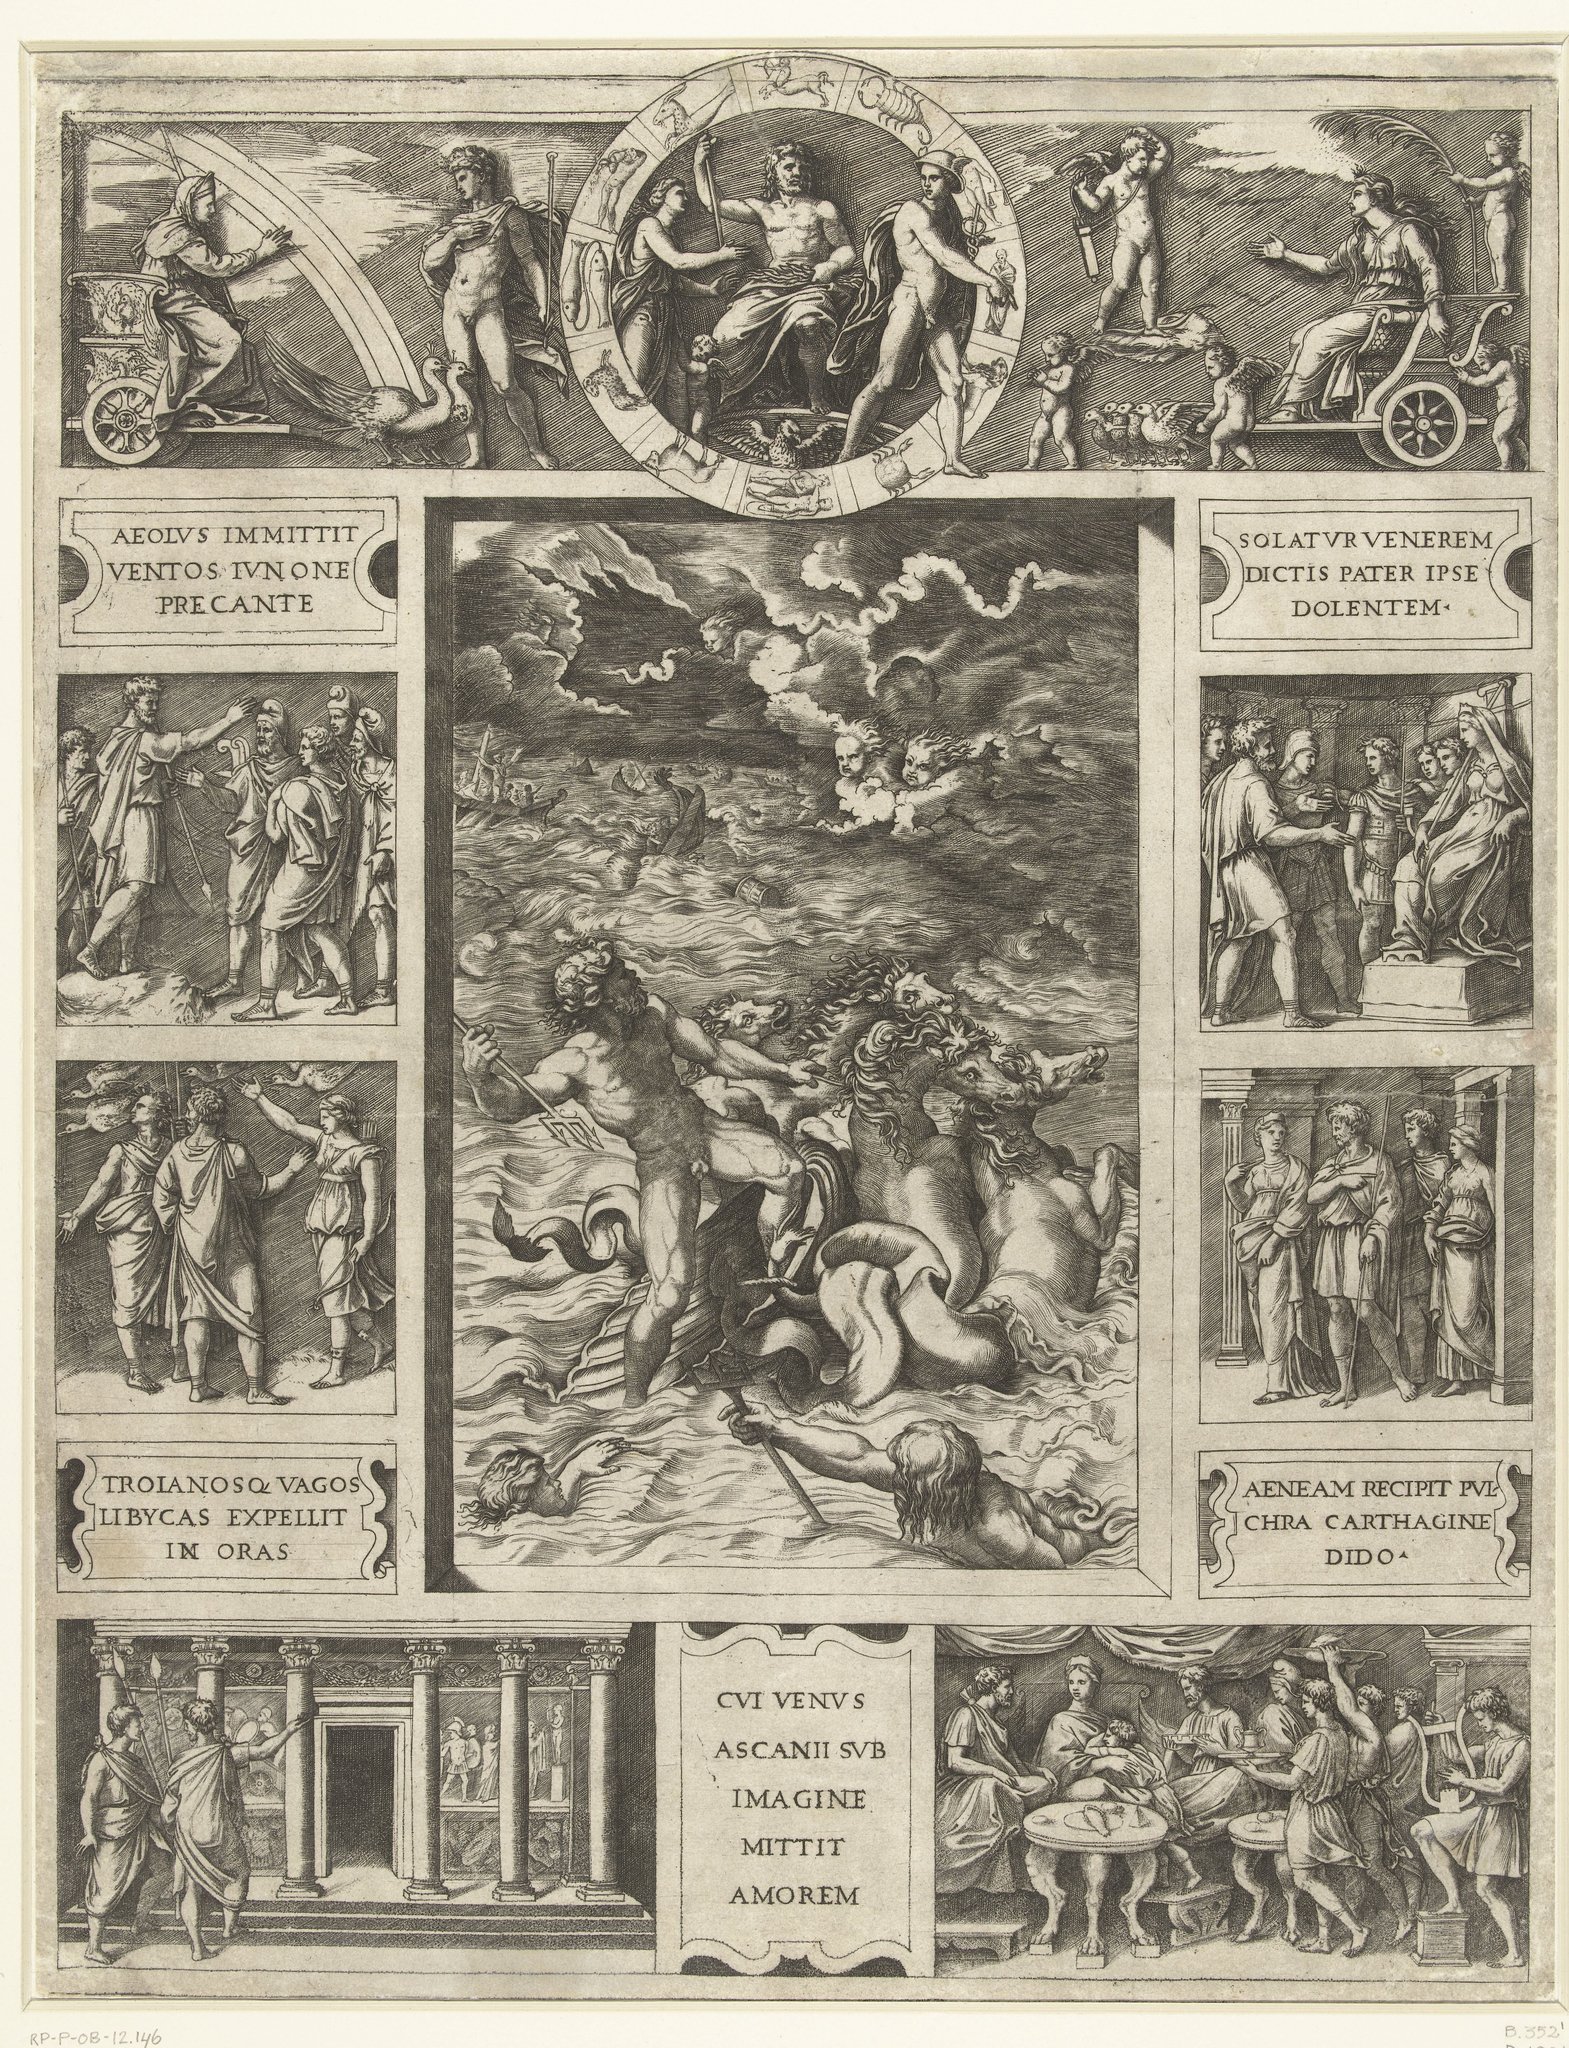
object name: print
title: Jupiter bedaart de storm op zee in rechthoekige omlijsting met negen scènes uit epos Aeneis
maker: marcantonio raimondi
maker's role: print maker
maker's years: 1470-1534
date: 1515-1516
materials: paper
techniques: engraving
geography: italy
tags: (story of) neptune (poseidon), the story of aeneas' wanderings to italy (virgil, aeneid), neptune quieting the storm, 'quos ego' (virgil, aeneid i 135)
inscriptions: collector's mark: Lugt 240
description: Jupiter bedaart de storm op zee in rechthoekige omlijsting met negen scènes uit epos Aeneis van Vergilius in willekeurige volgorde weergegeven. De voorstellingen worden geduid met Latijnse teksten.